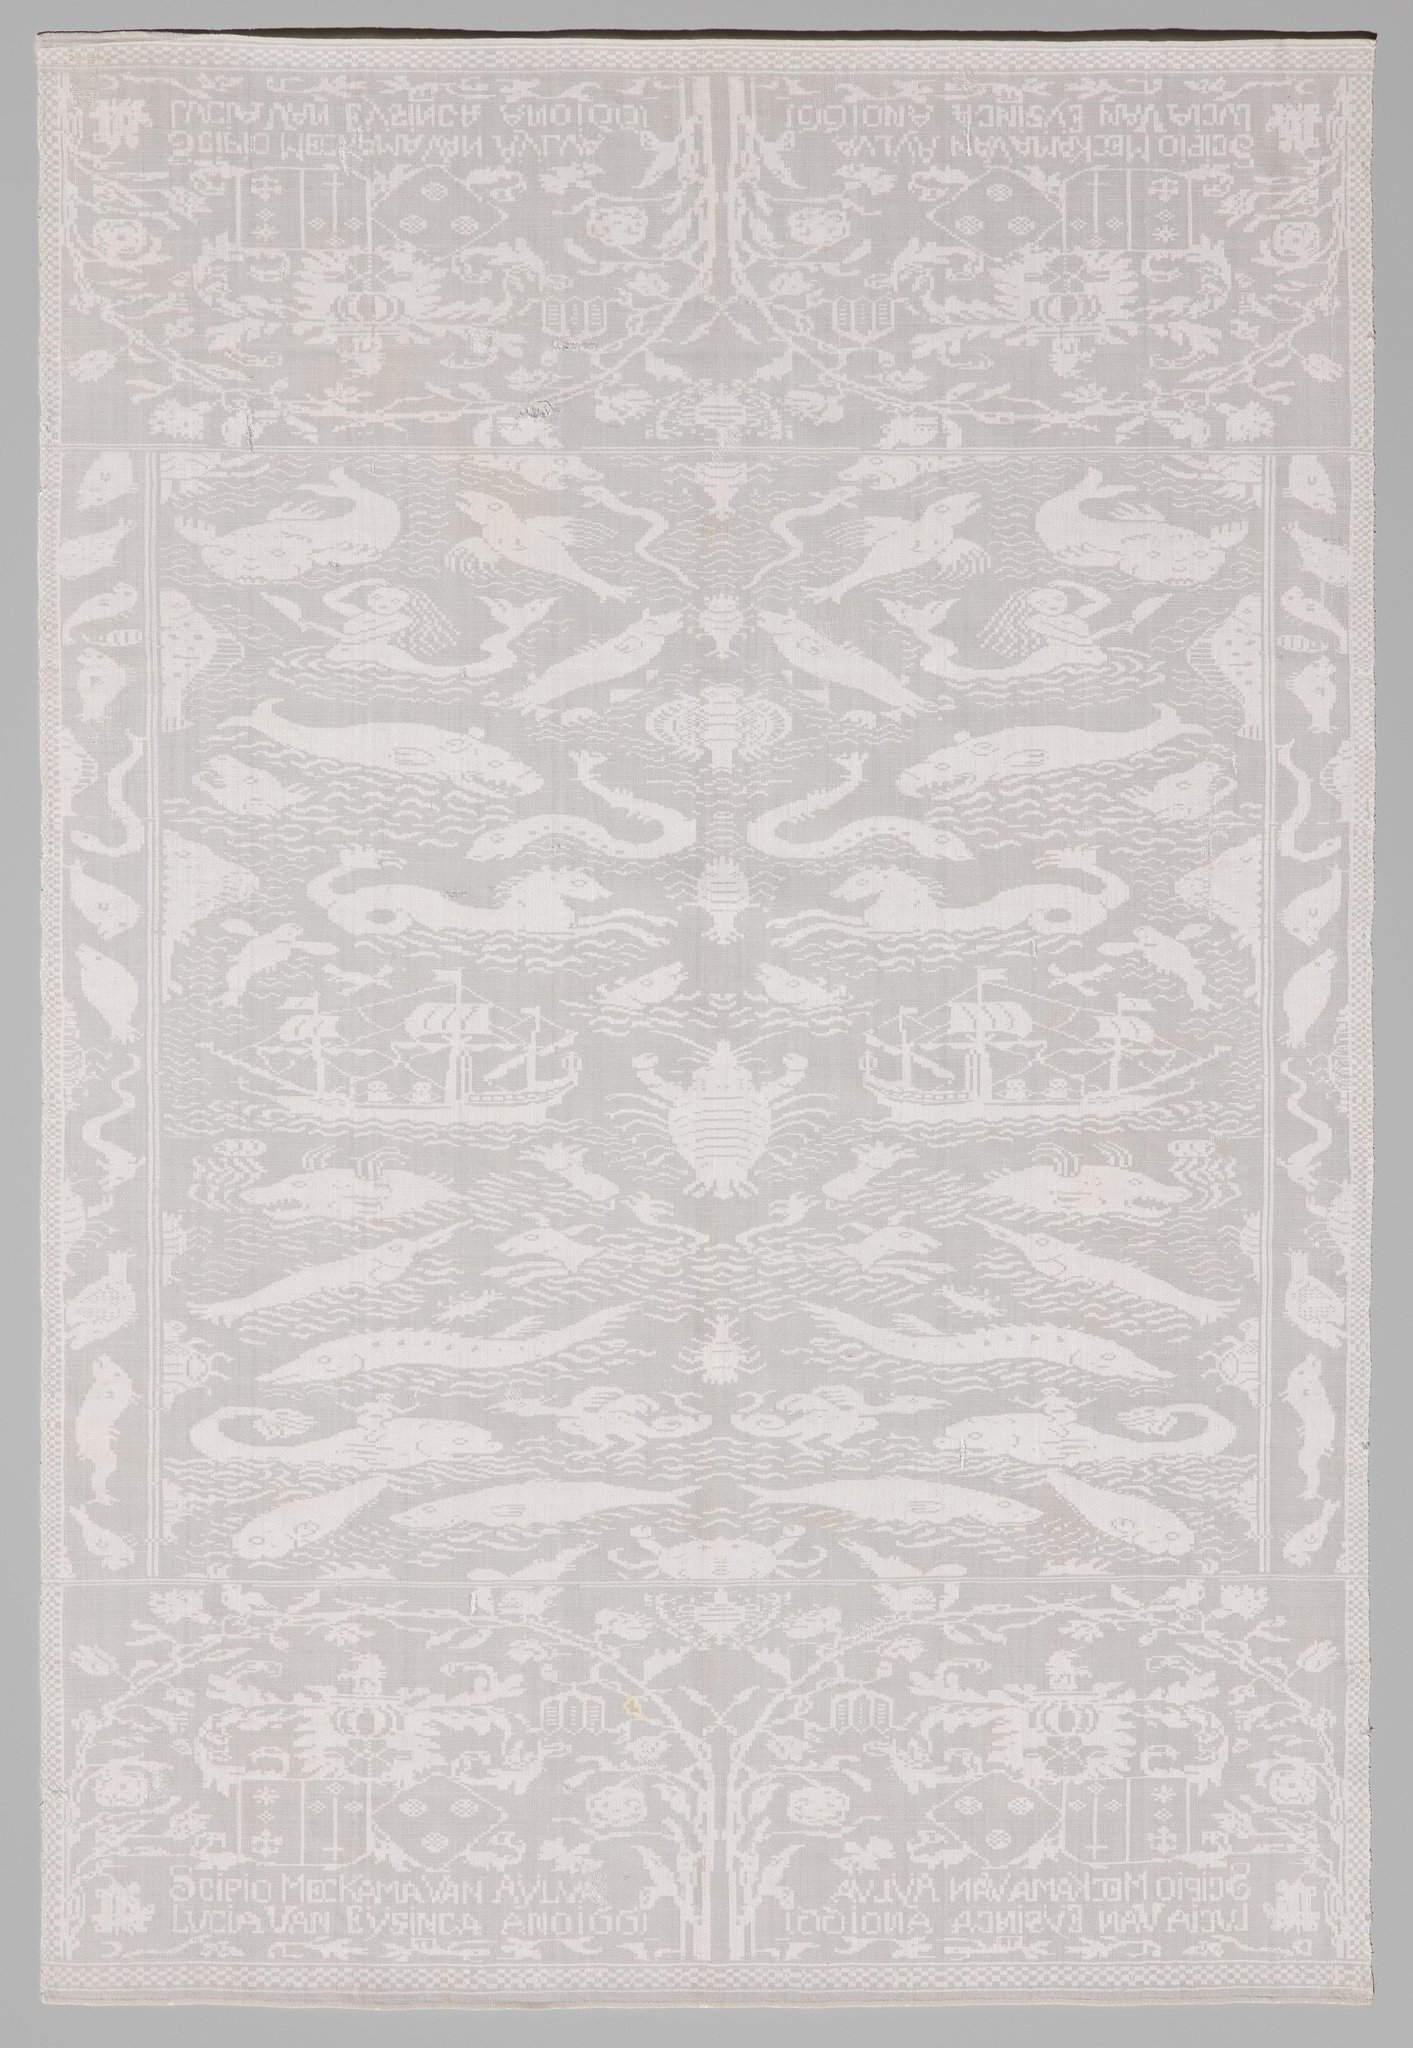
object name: napkin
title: Servet met schepen, vissen en de wapens van Scipio Meckama van Aijlva en Lucia van Eysinga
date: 1661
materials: linen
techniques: damask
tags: lucia van eysinga, scipio meckama van aijlva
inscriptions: mark: ‘L.V.A. 1661’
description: Servet van linnendamast met schepen, vissen en de wapens van Scipio Meckama van Aijlva en Lucia van Eysinga. Middenveld: het symmetrisch patroon vertoont: twee schepen, dolfijnen, zeemeerminnen, zeepaarden en diverse vissen. Staande randen: vis- en schaaldieren. In de brede liggende randen: een tak met bloemen, waaronder twee wapens met de onderschriften SCIPIO MECKAMA VAN ALVA en LUCIA VAN EYSINGA ANO 1661. In de hoeken geborduurd L.V.A. 1661.